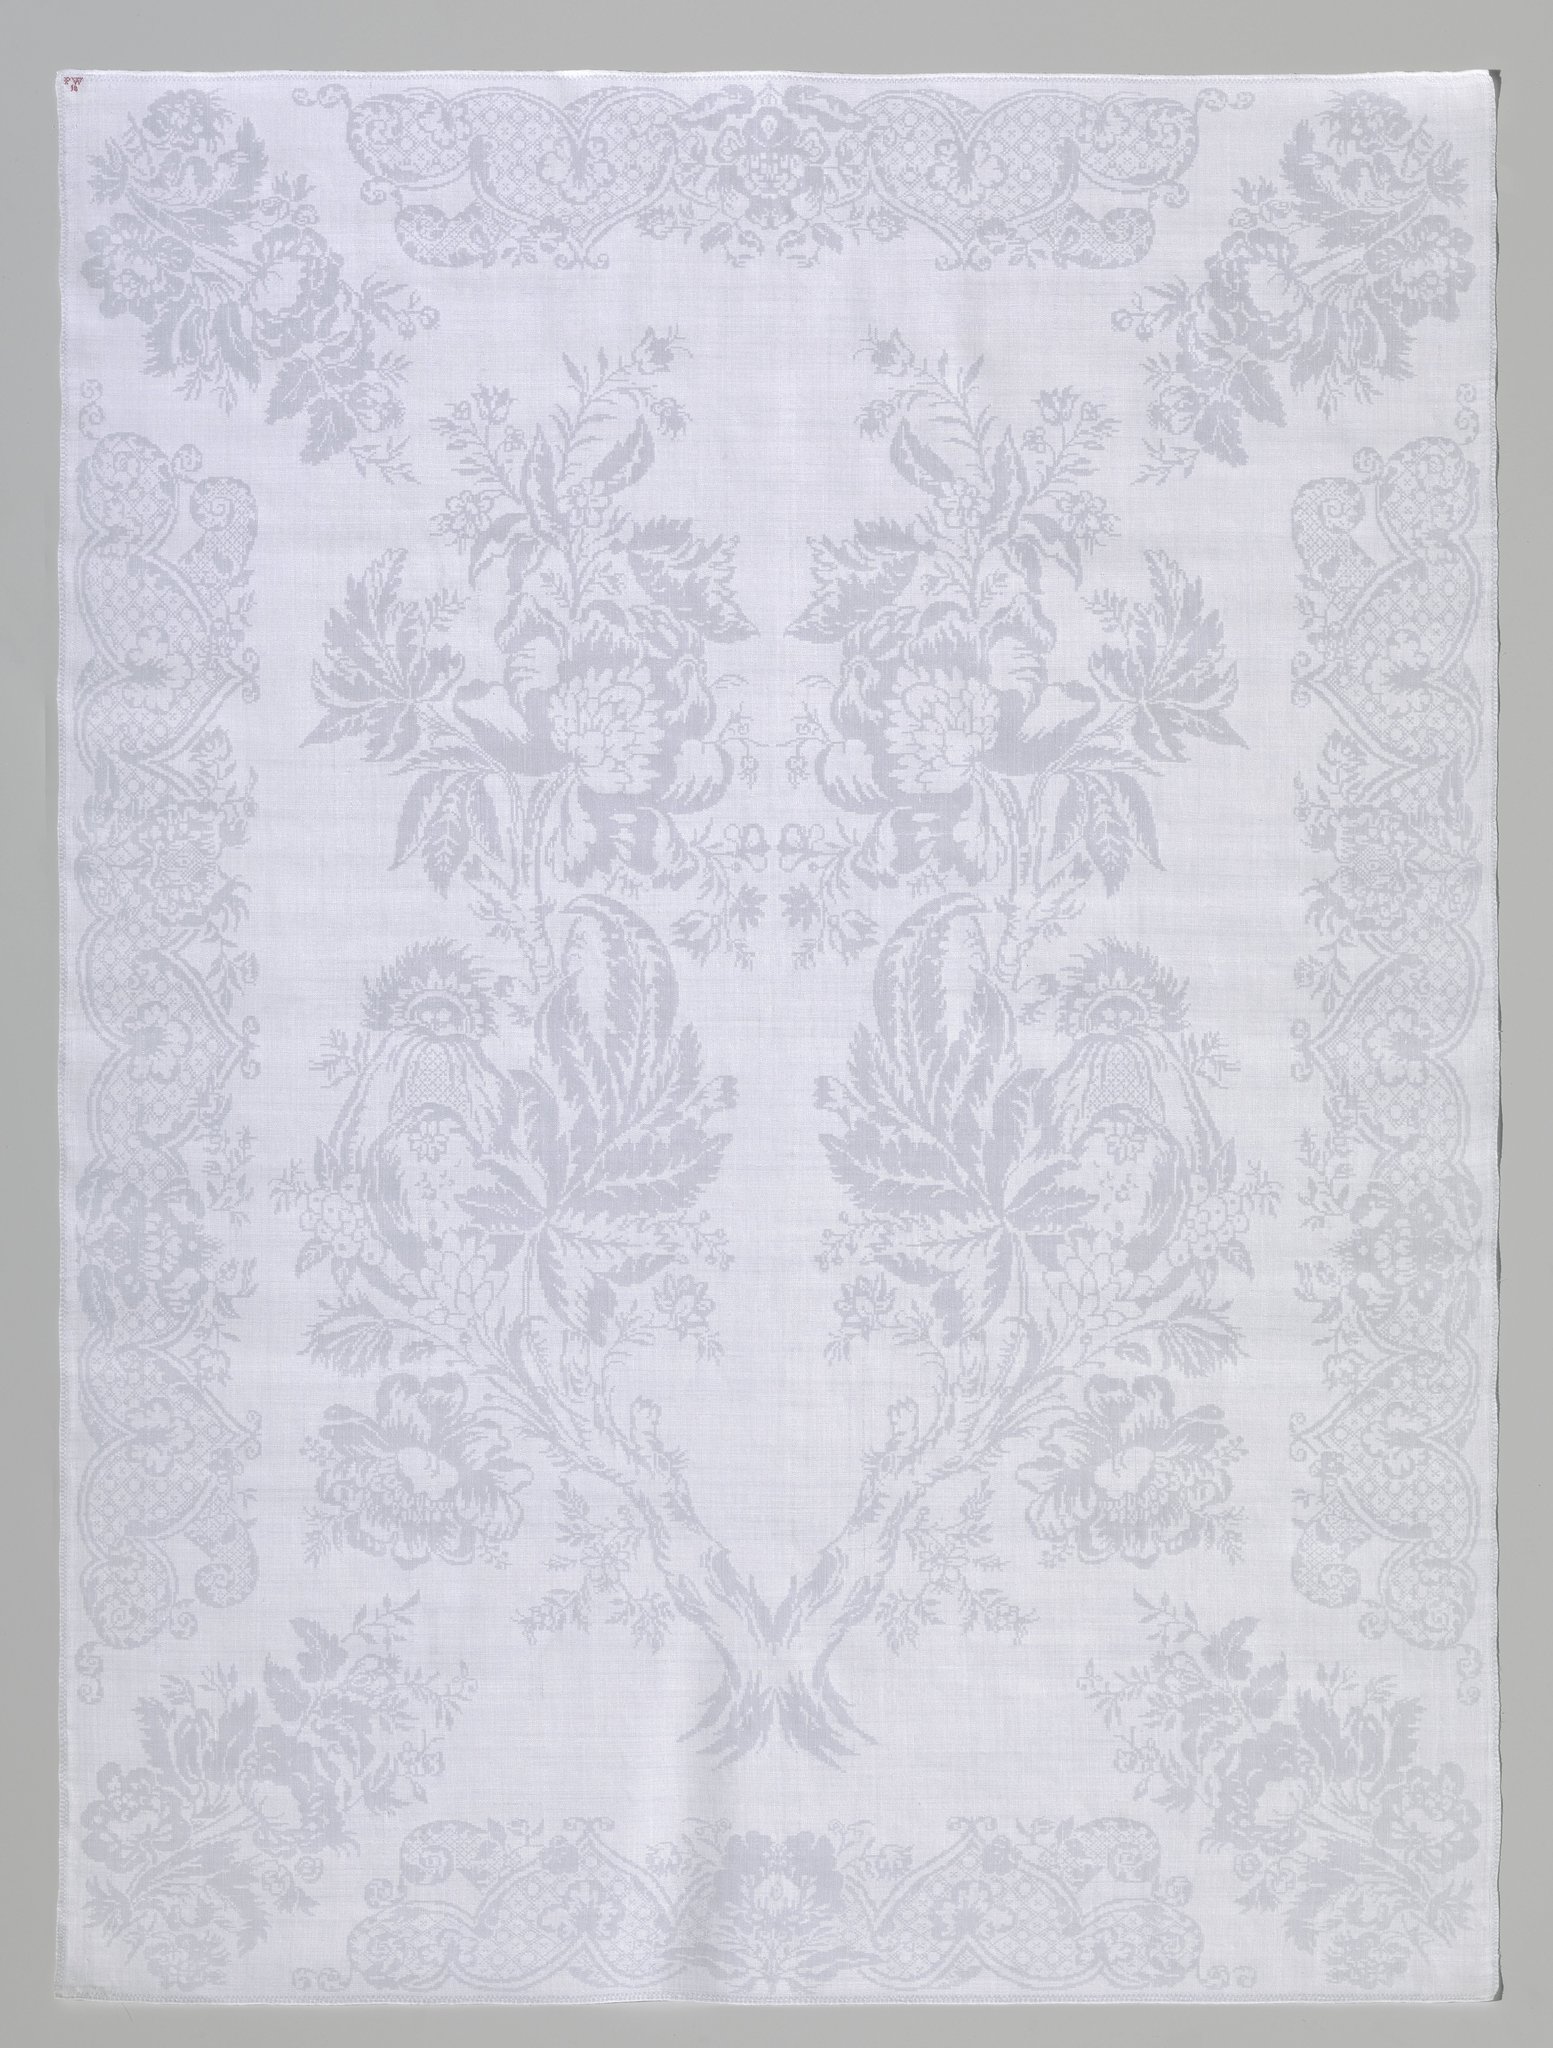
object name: napkin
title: Servet van linnendamast met een bloempatroon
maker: Anonymous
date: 1732-1735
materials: linen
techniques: damask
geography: flanders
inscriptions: : ‘PW 18’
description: Servet van linnendamast met een tak met grote bloemen en vruchten. Bij het servet hoort een servet (BK-1977-291-B).